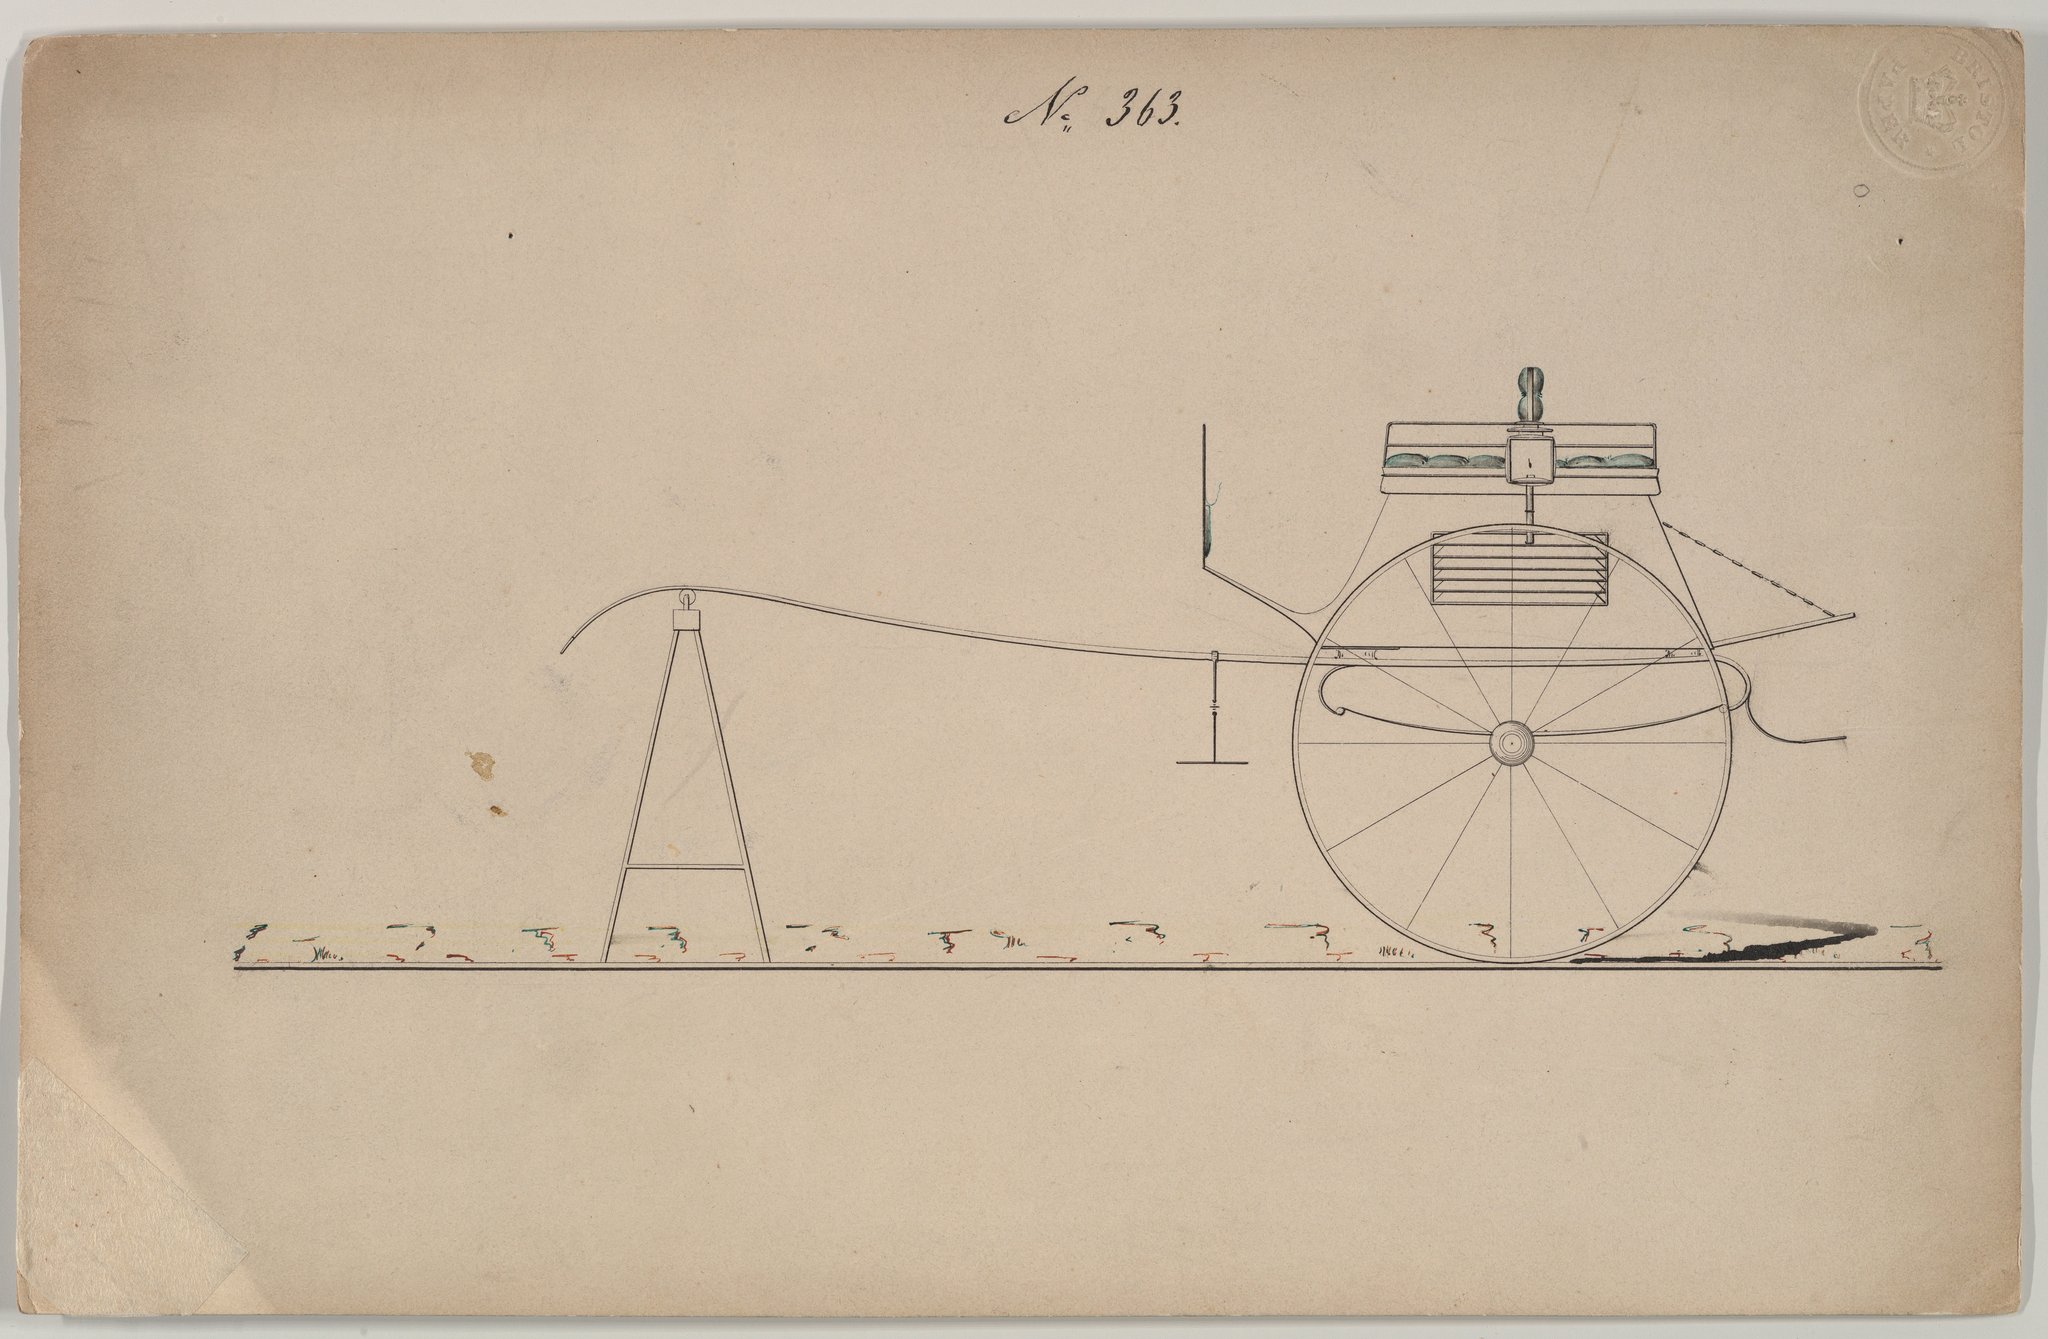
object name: drawing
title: Dog Cart #363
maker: brewster & co.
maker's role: manufacturer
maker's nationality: american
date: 1850-1865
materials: ink, watercolor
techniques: pen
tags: carriages